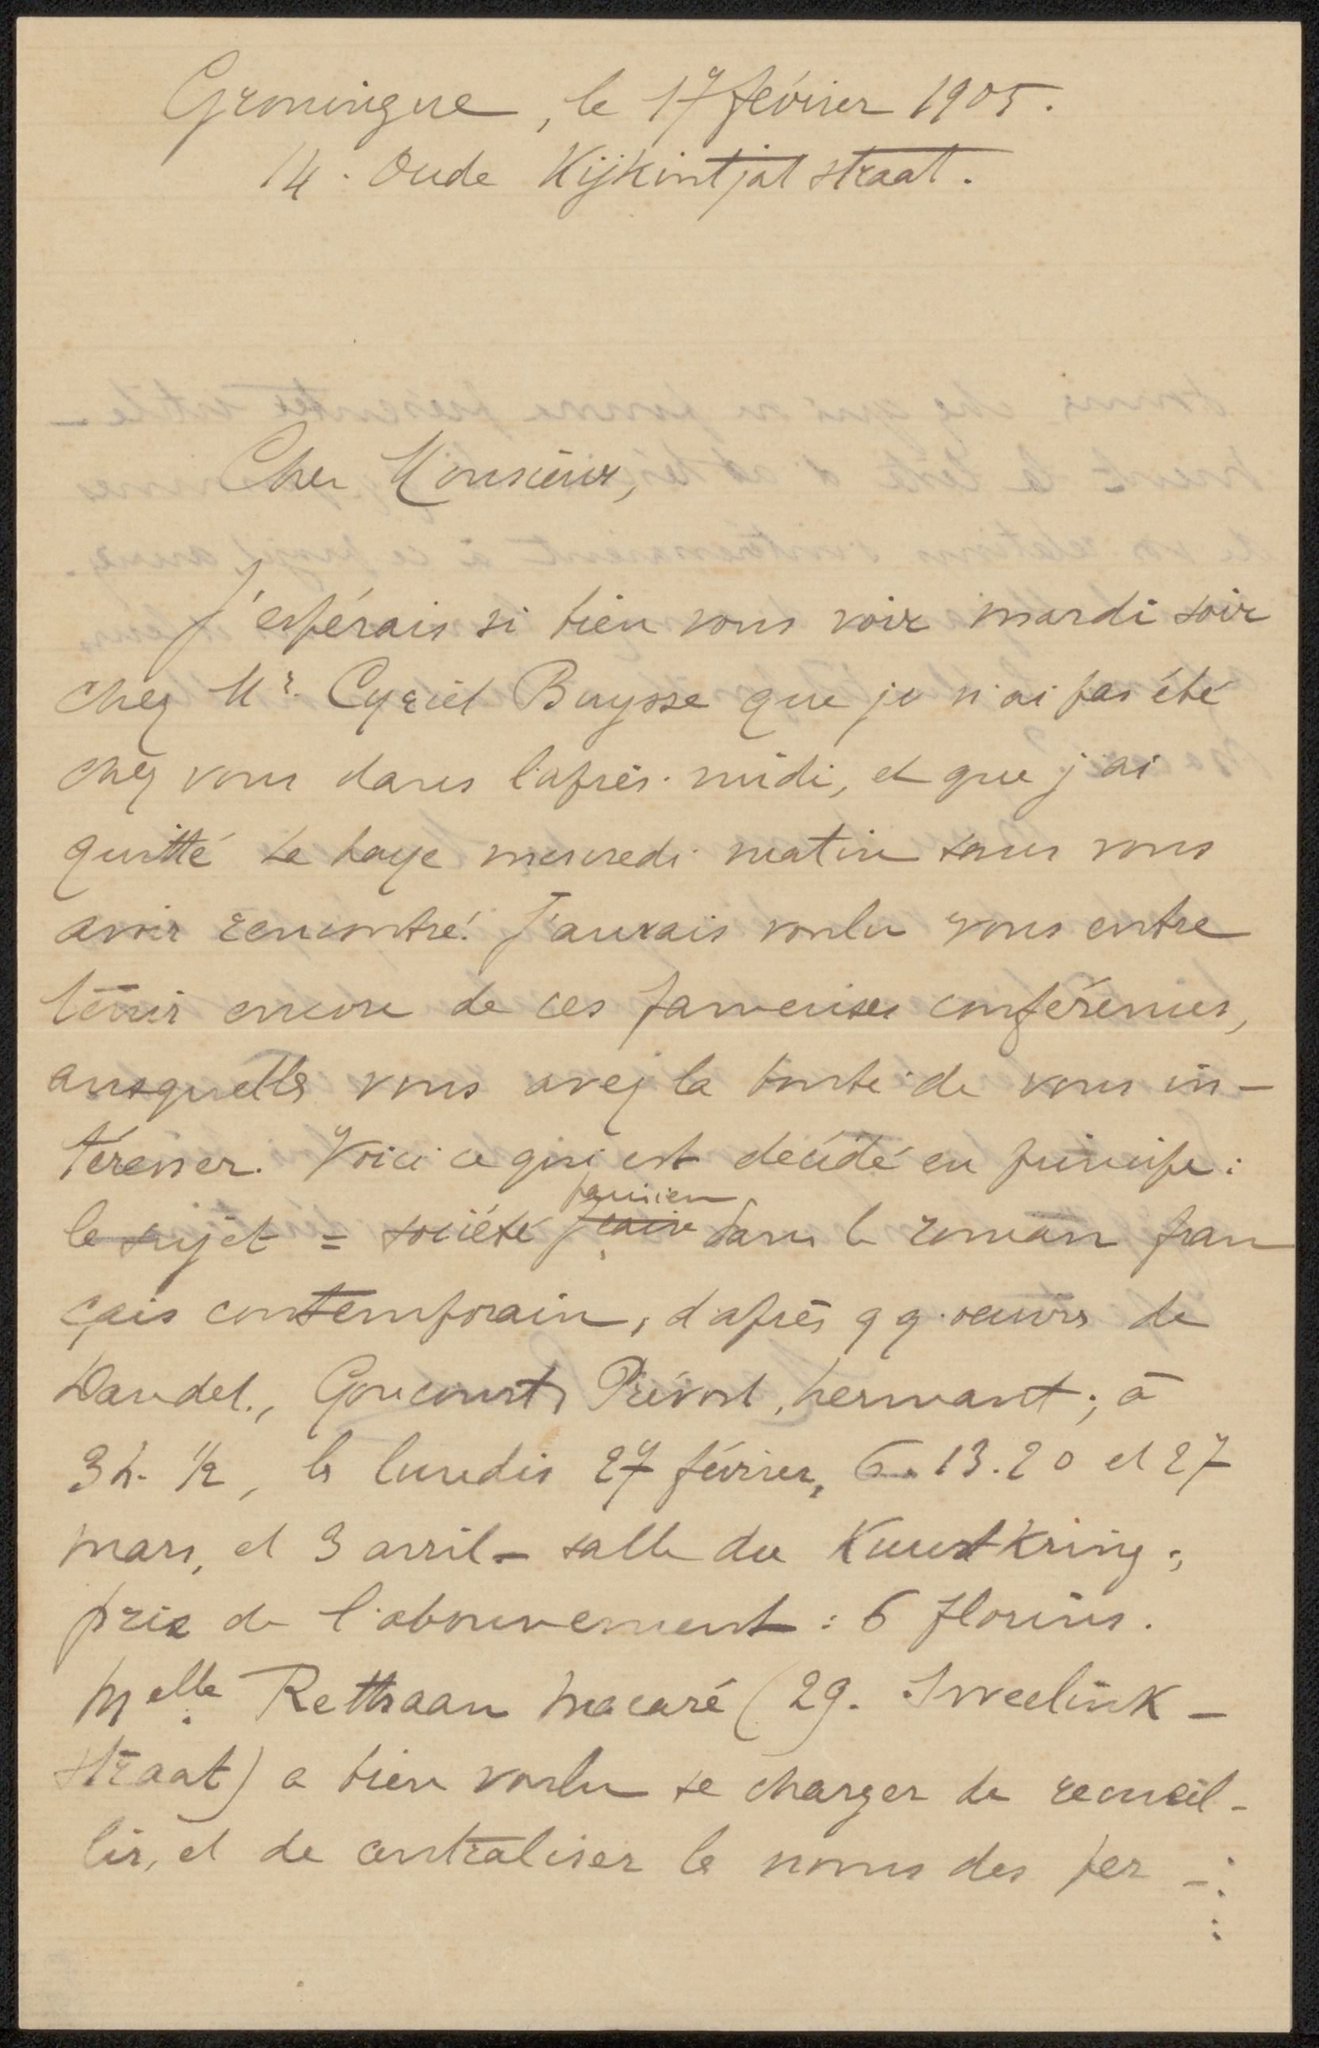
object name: letter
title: Brief aan Philip Zilcken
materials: ink, pencil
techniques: pen, writing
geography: groningen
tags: cyriel buysse, paris, alphonse daudet, the hague, painter, philip zilcken, literature ~ arts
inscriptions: collector's mark